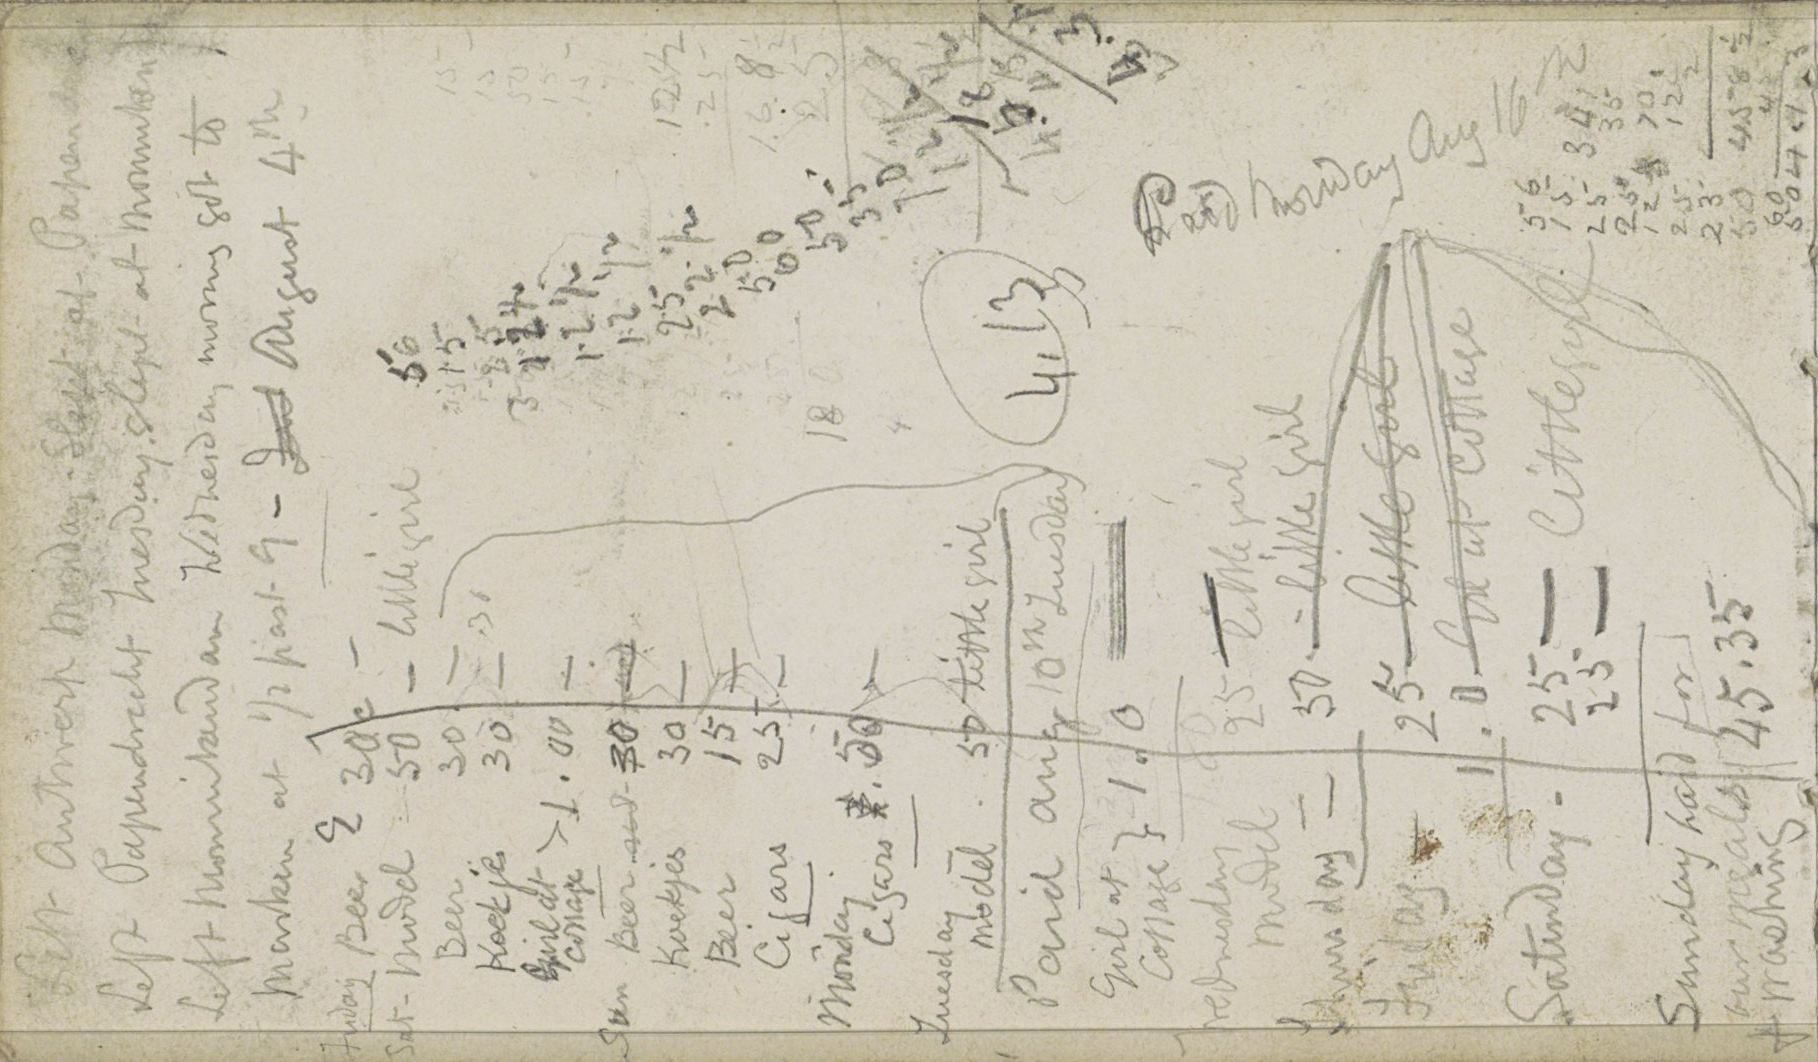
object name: sketchbook leaf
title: Reisnotities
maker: george clausen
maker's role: draughtsman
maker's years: 1852-1912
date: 1875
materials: paper, pencil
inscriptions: annotation: ‘[...]’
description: Blad 2 verso uit een schetsboek met 46 bladen.